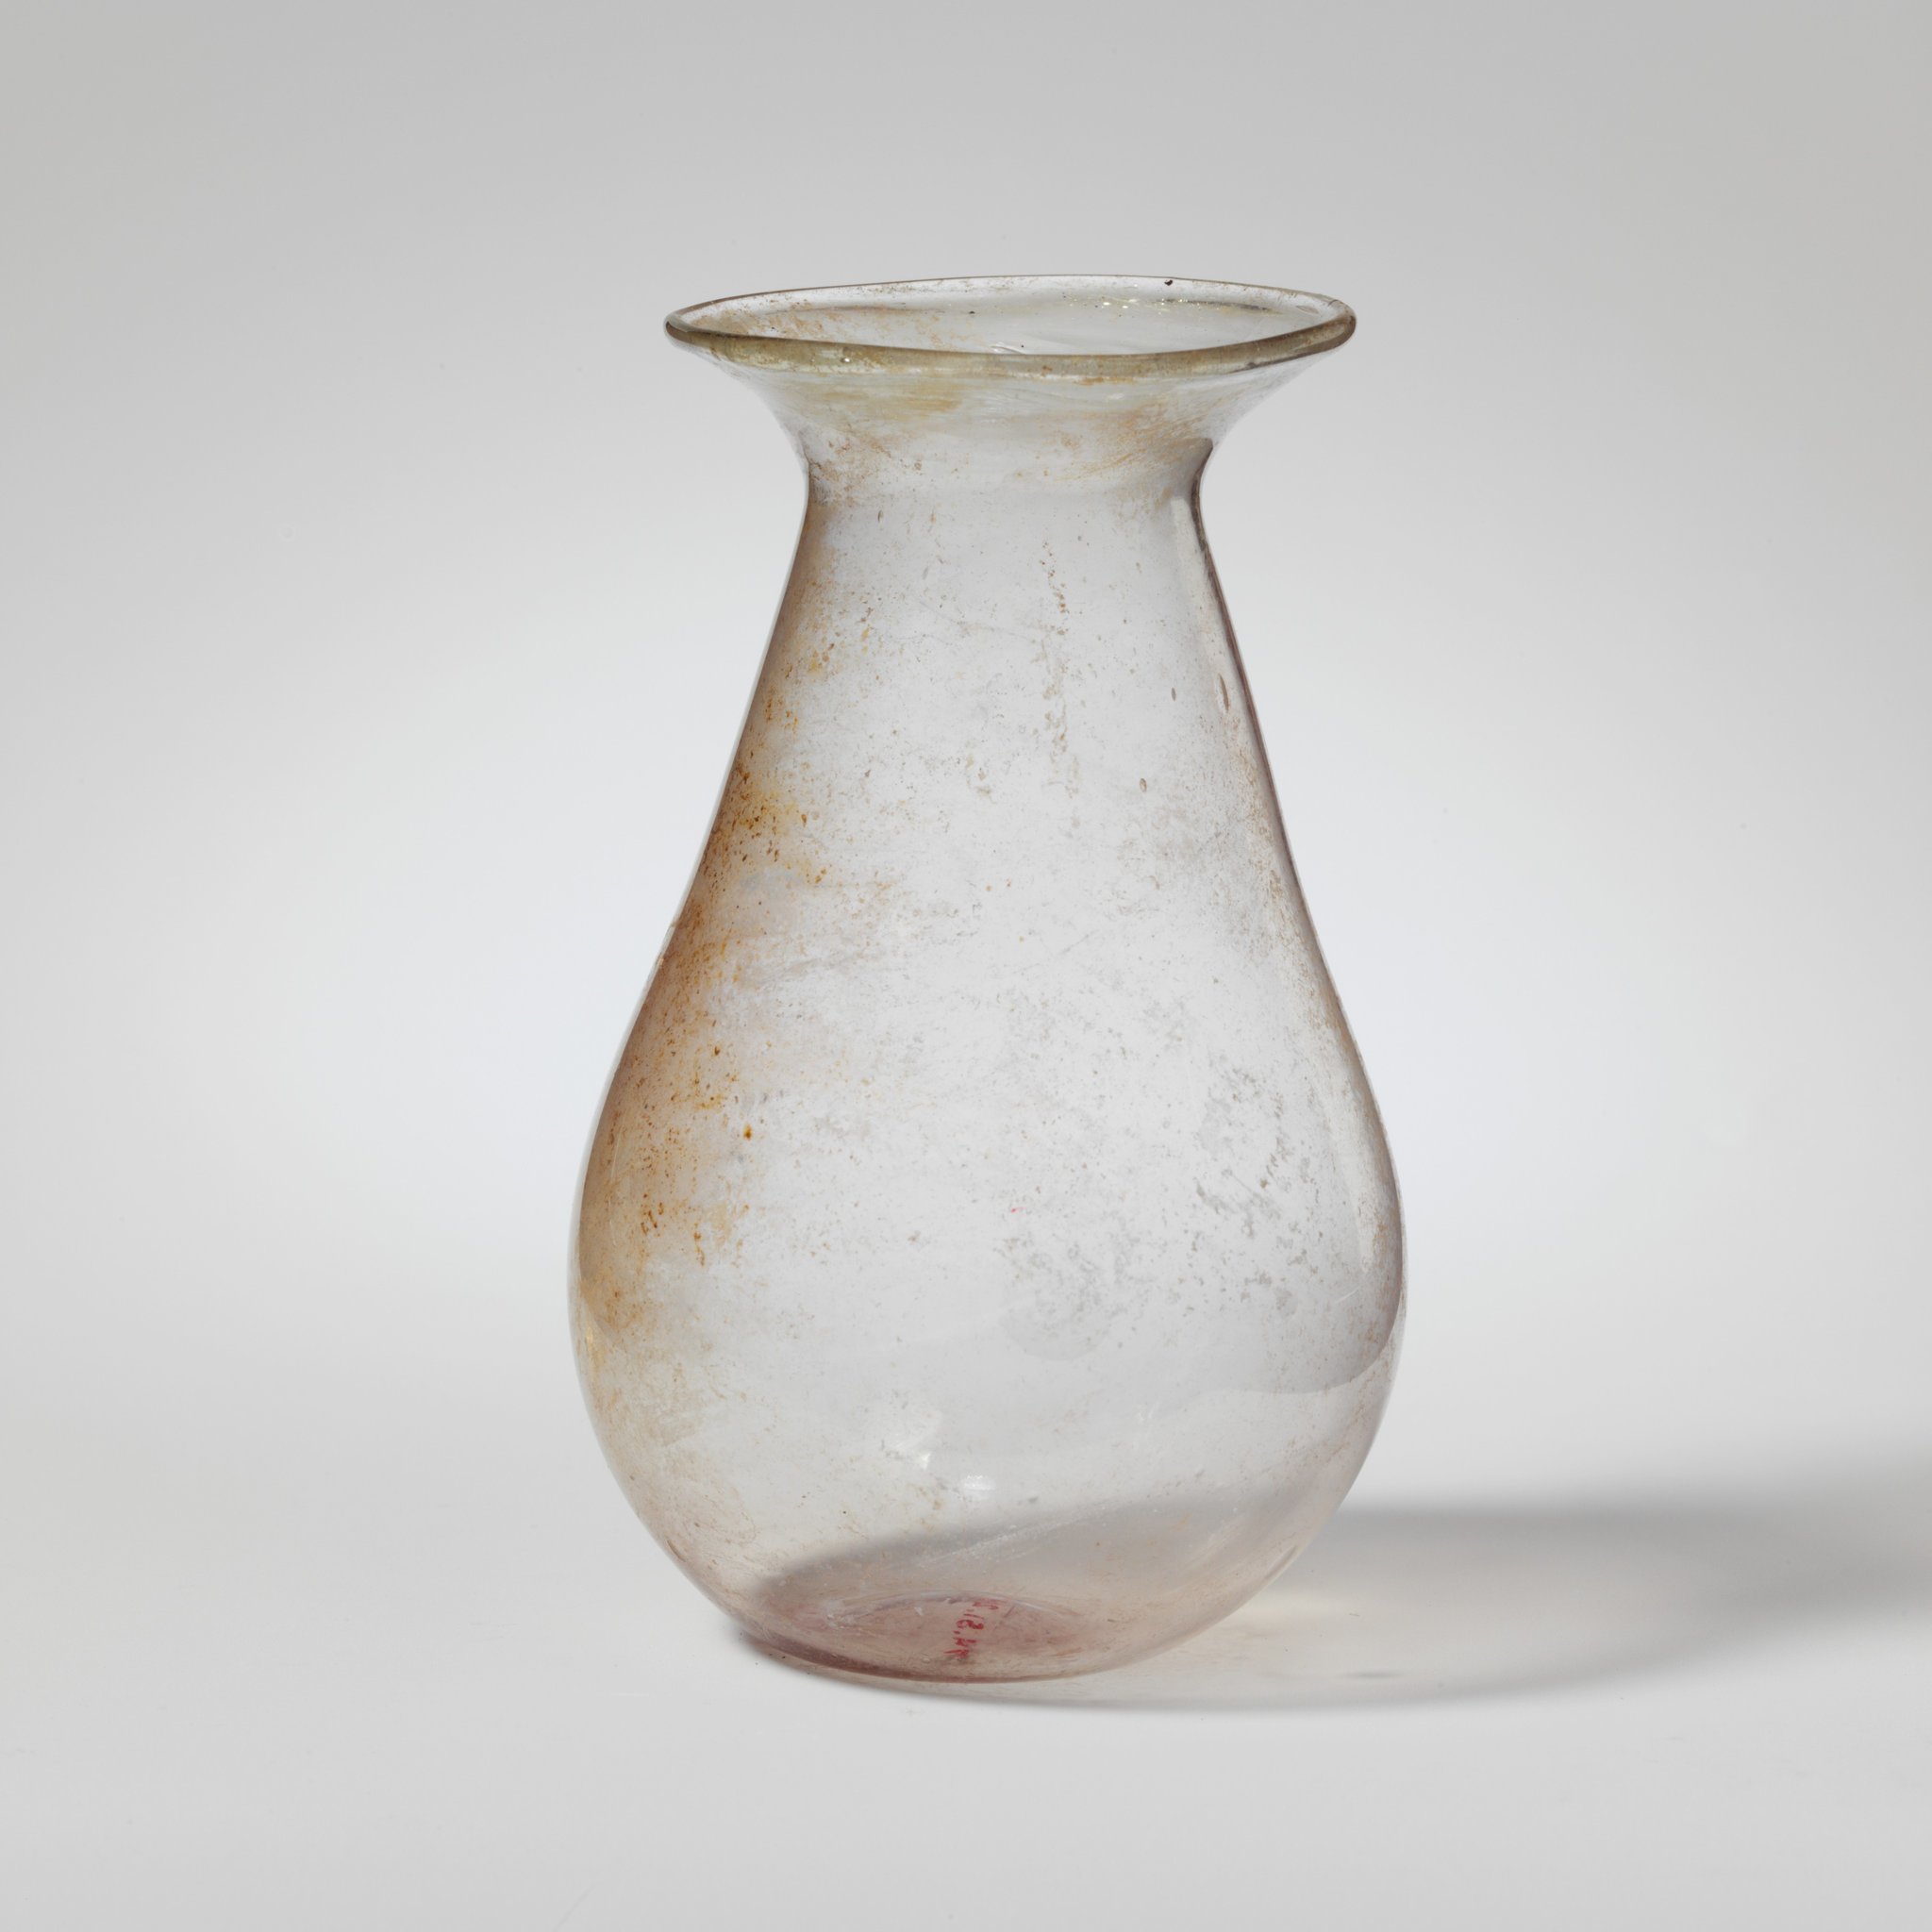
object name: jar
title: Glass jar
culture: roman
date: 101-300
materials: glass